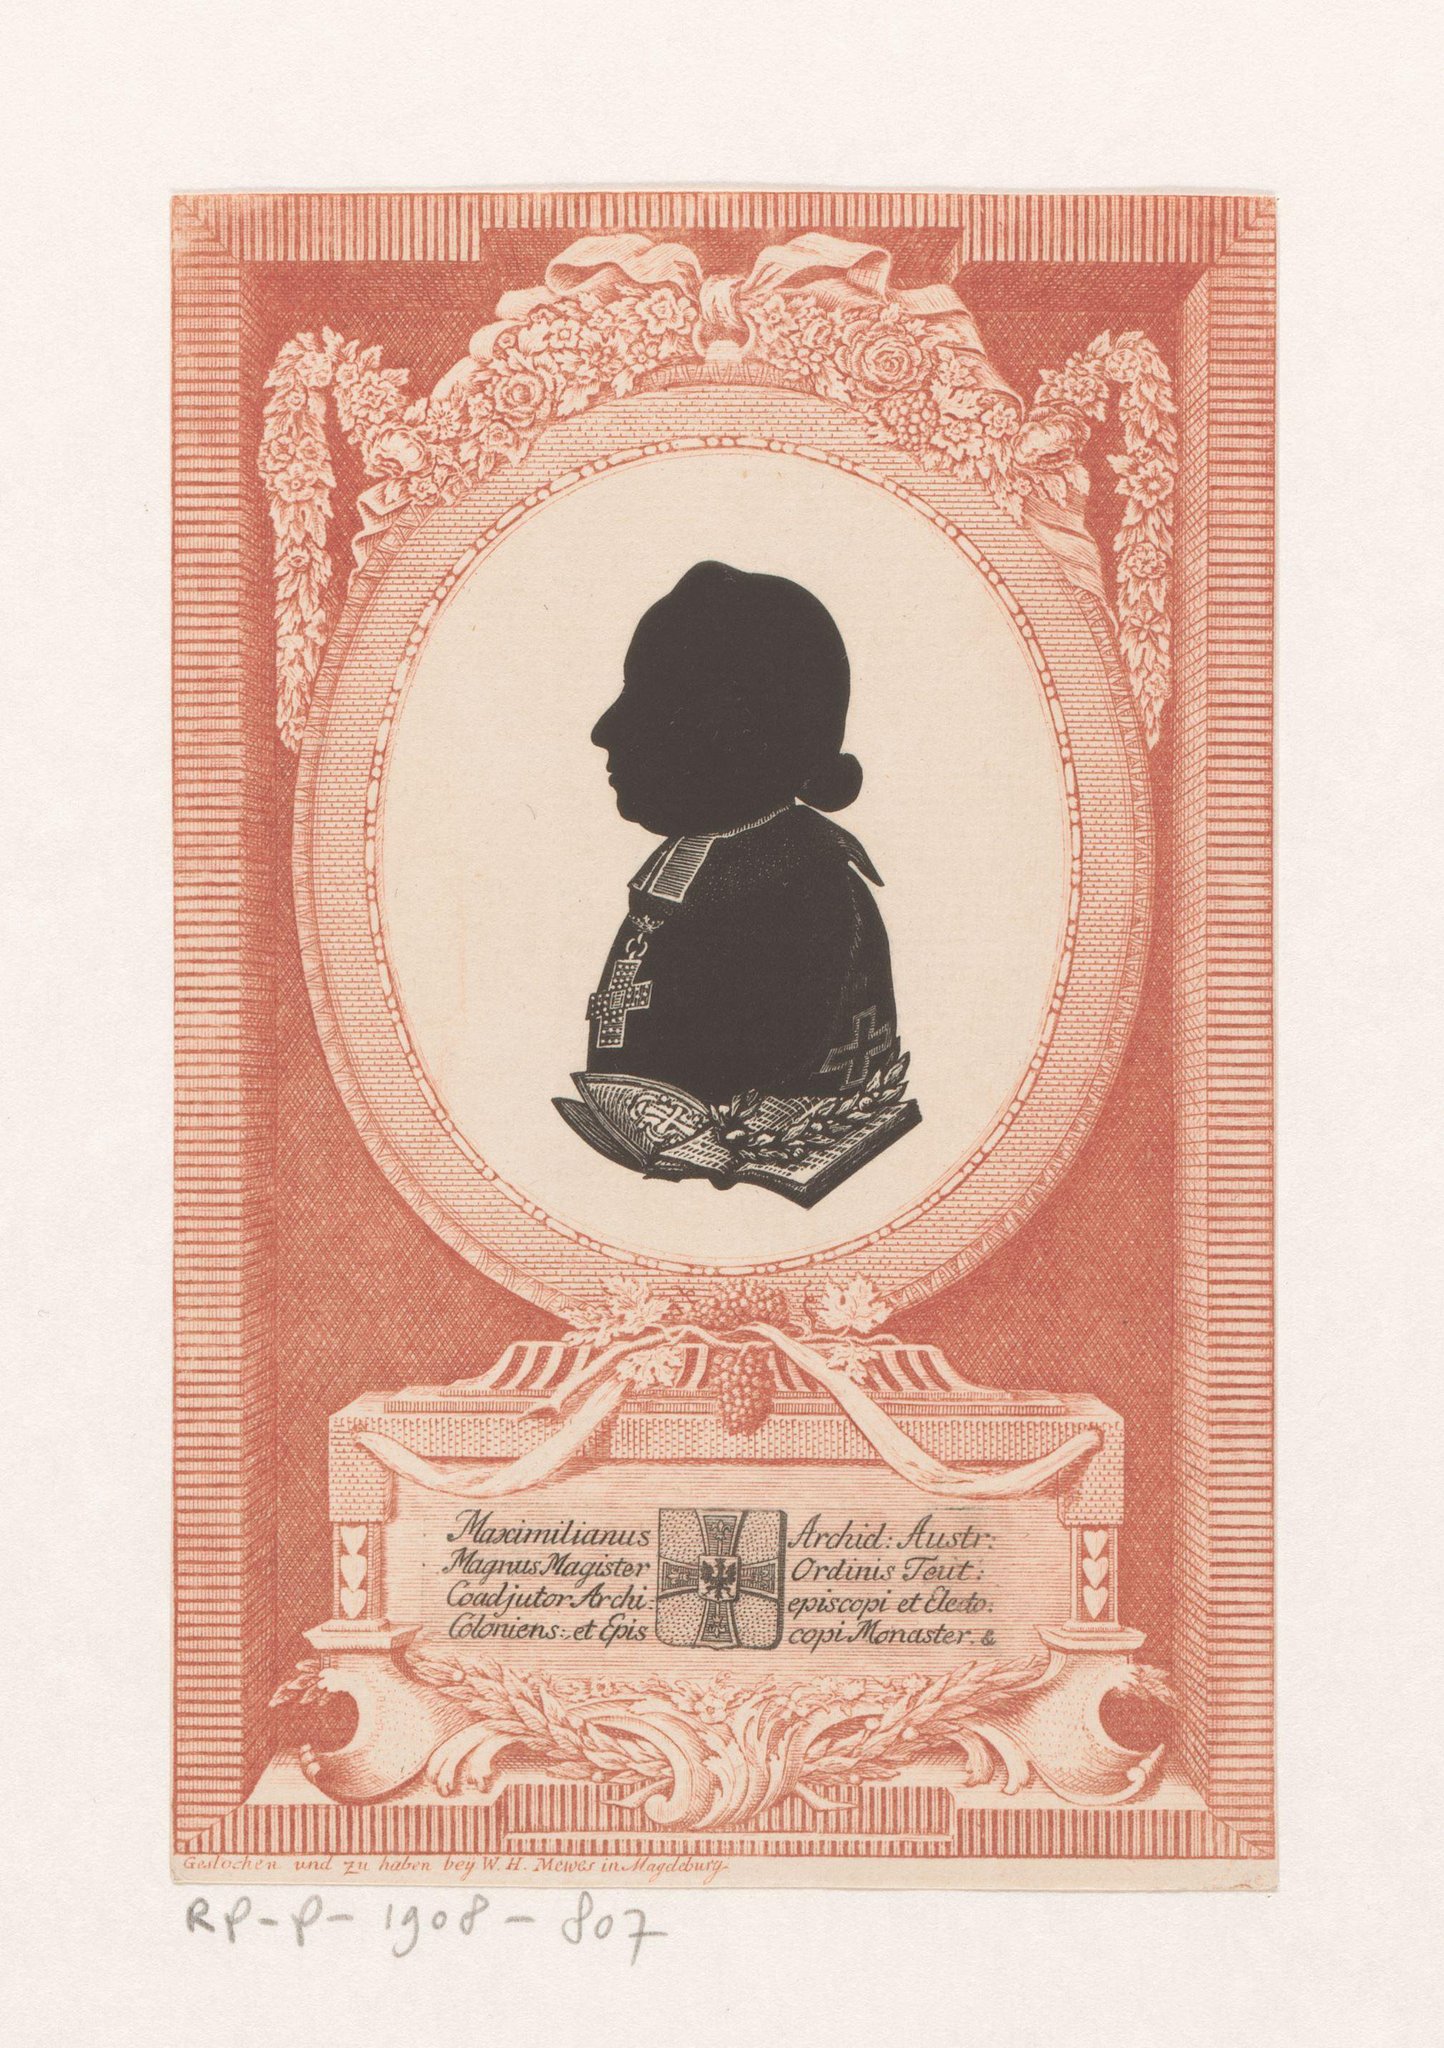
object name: print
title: Silhouetportret van koning Maximiliaan I Jozef van Beieren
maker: w.h. mewes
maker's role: print maker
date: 1795-1799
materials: paper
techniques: engraving, etching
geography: magdeburg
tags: maximiliaan i jozef (koning van beieren), historical persons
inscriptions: collector's mark: Lugt 2228